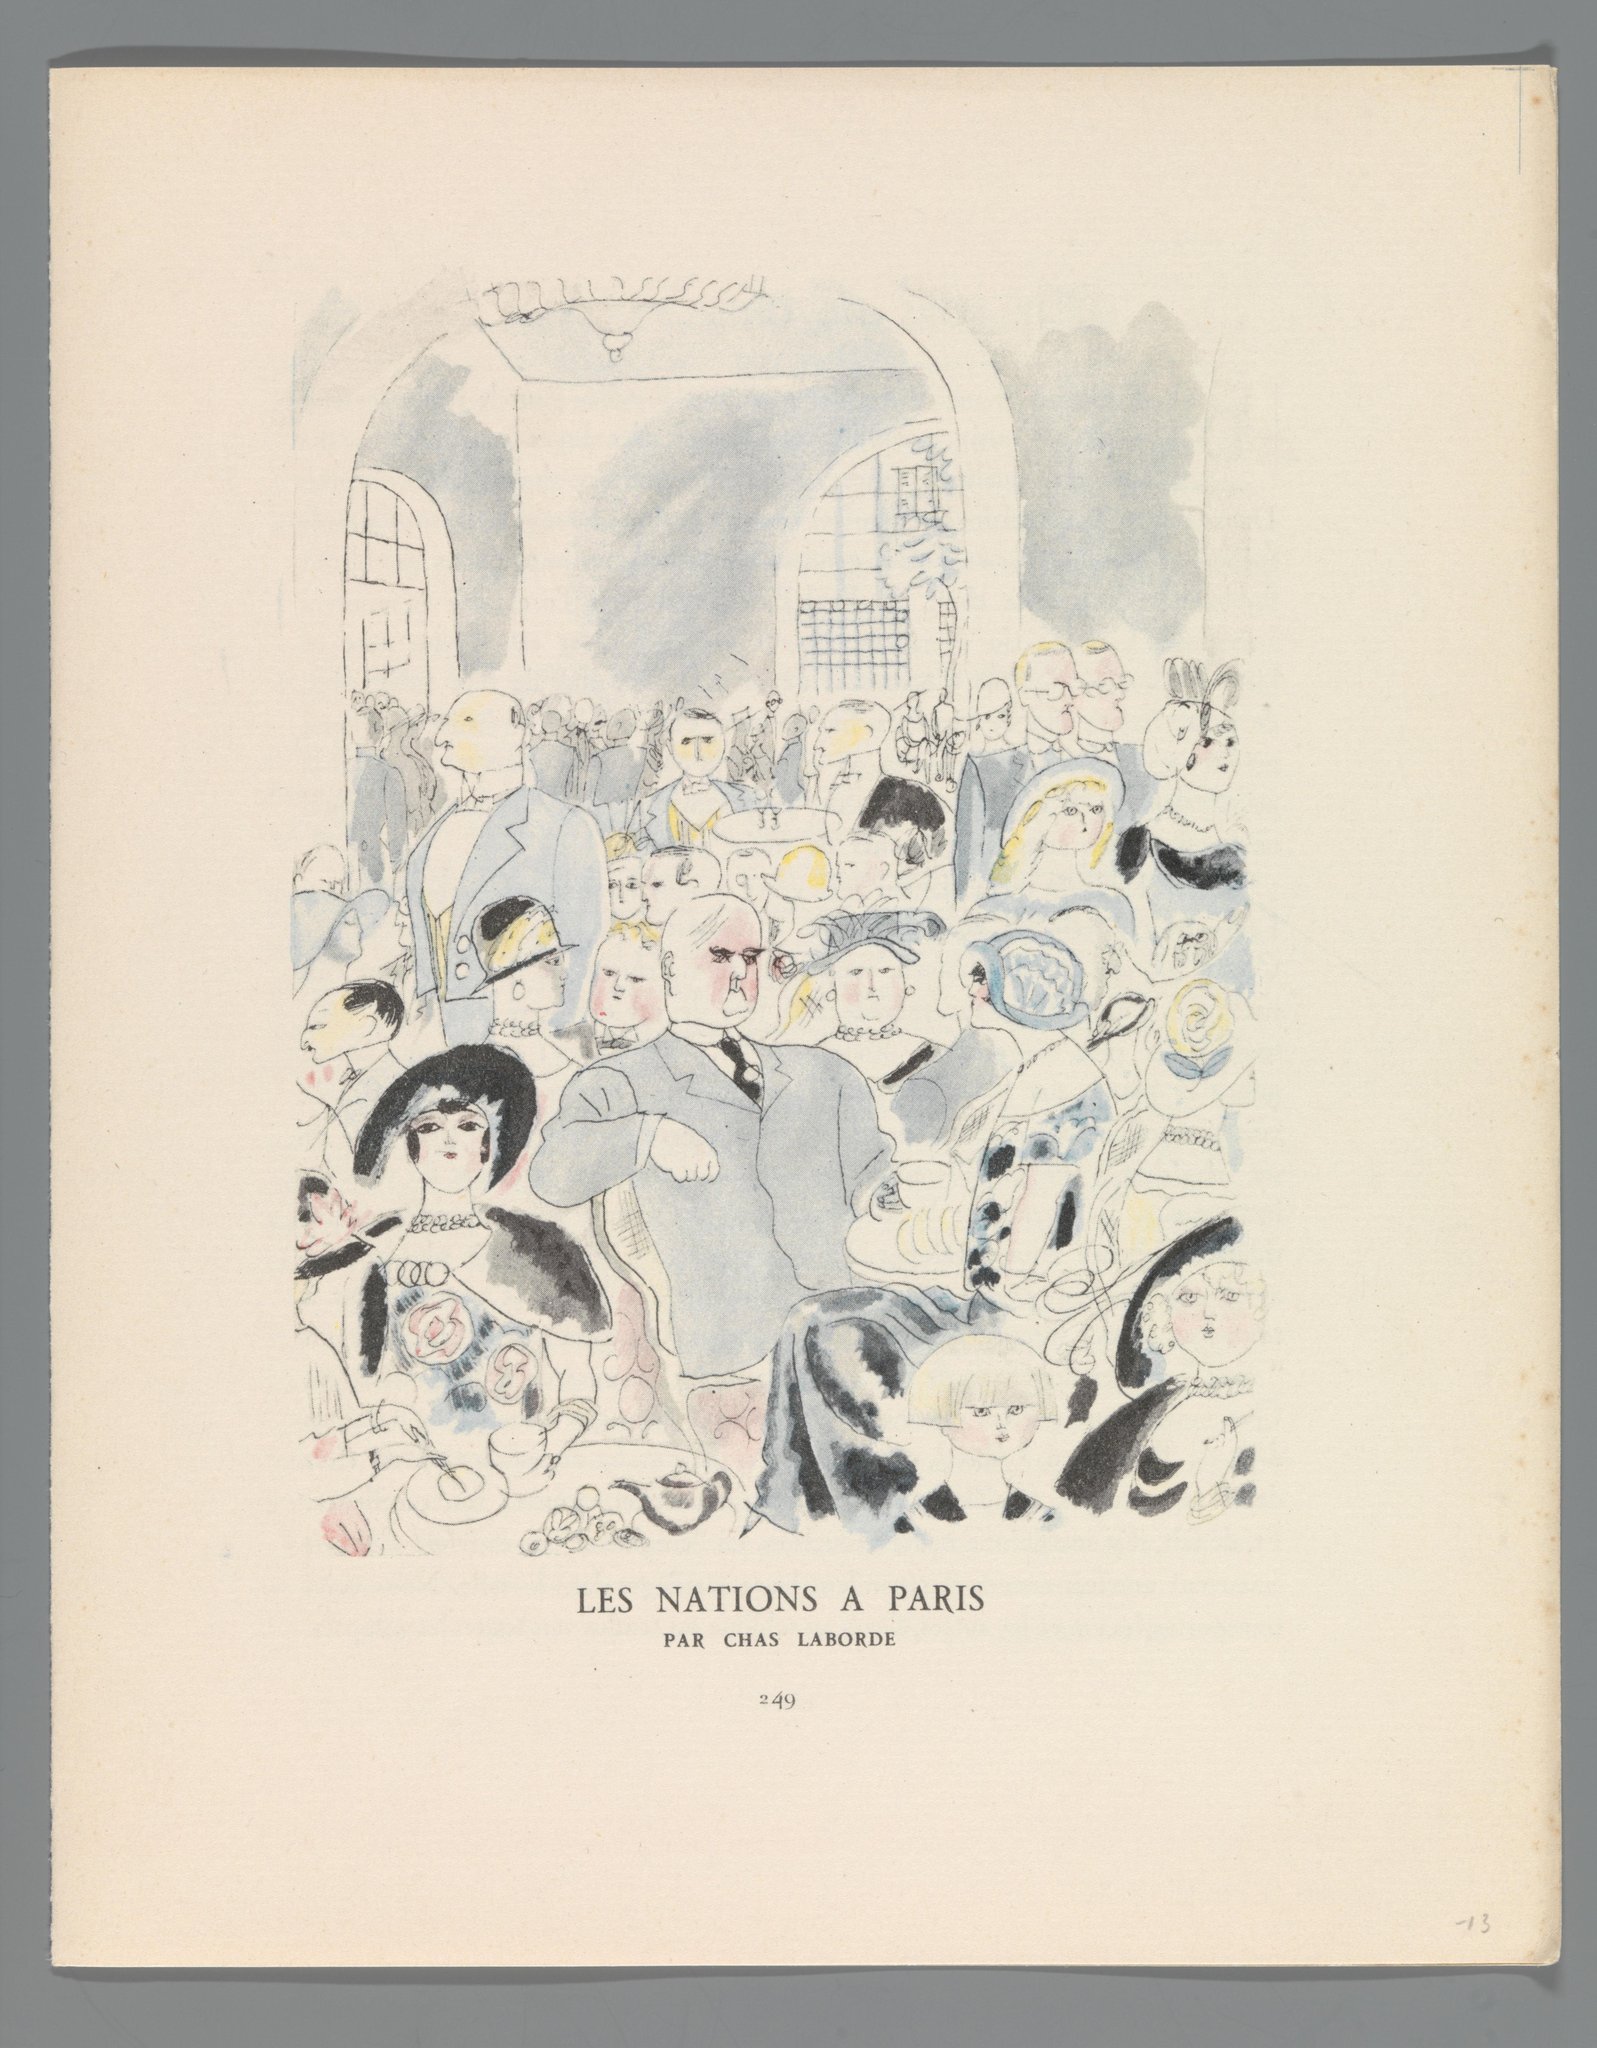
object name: fashion print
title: Gazette du Bon Ton, 1924 - No. 6 : p. 249: Les Nations à Paris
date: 1924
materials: paper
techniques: letterpress printing, photochemical processes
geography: paris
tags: ear-rings (+ women's clothes), perfume bottle - aa - (for) women, perfumes - aa - (for) women, fashion plates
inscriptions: date